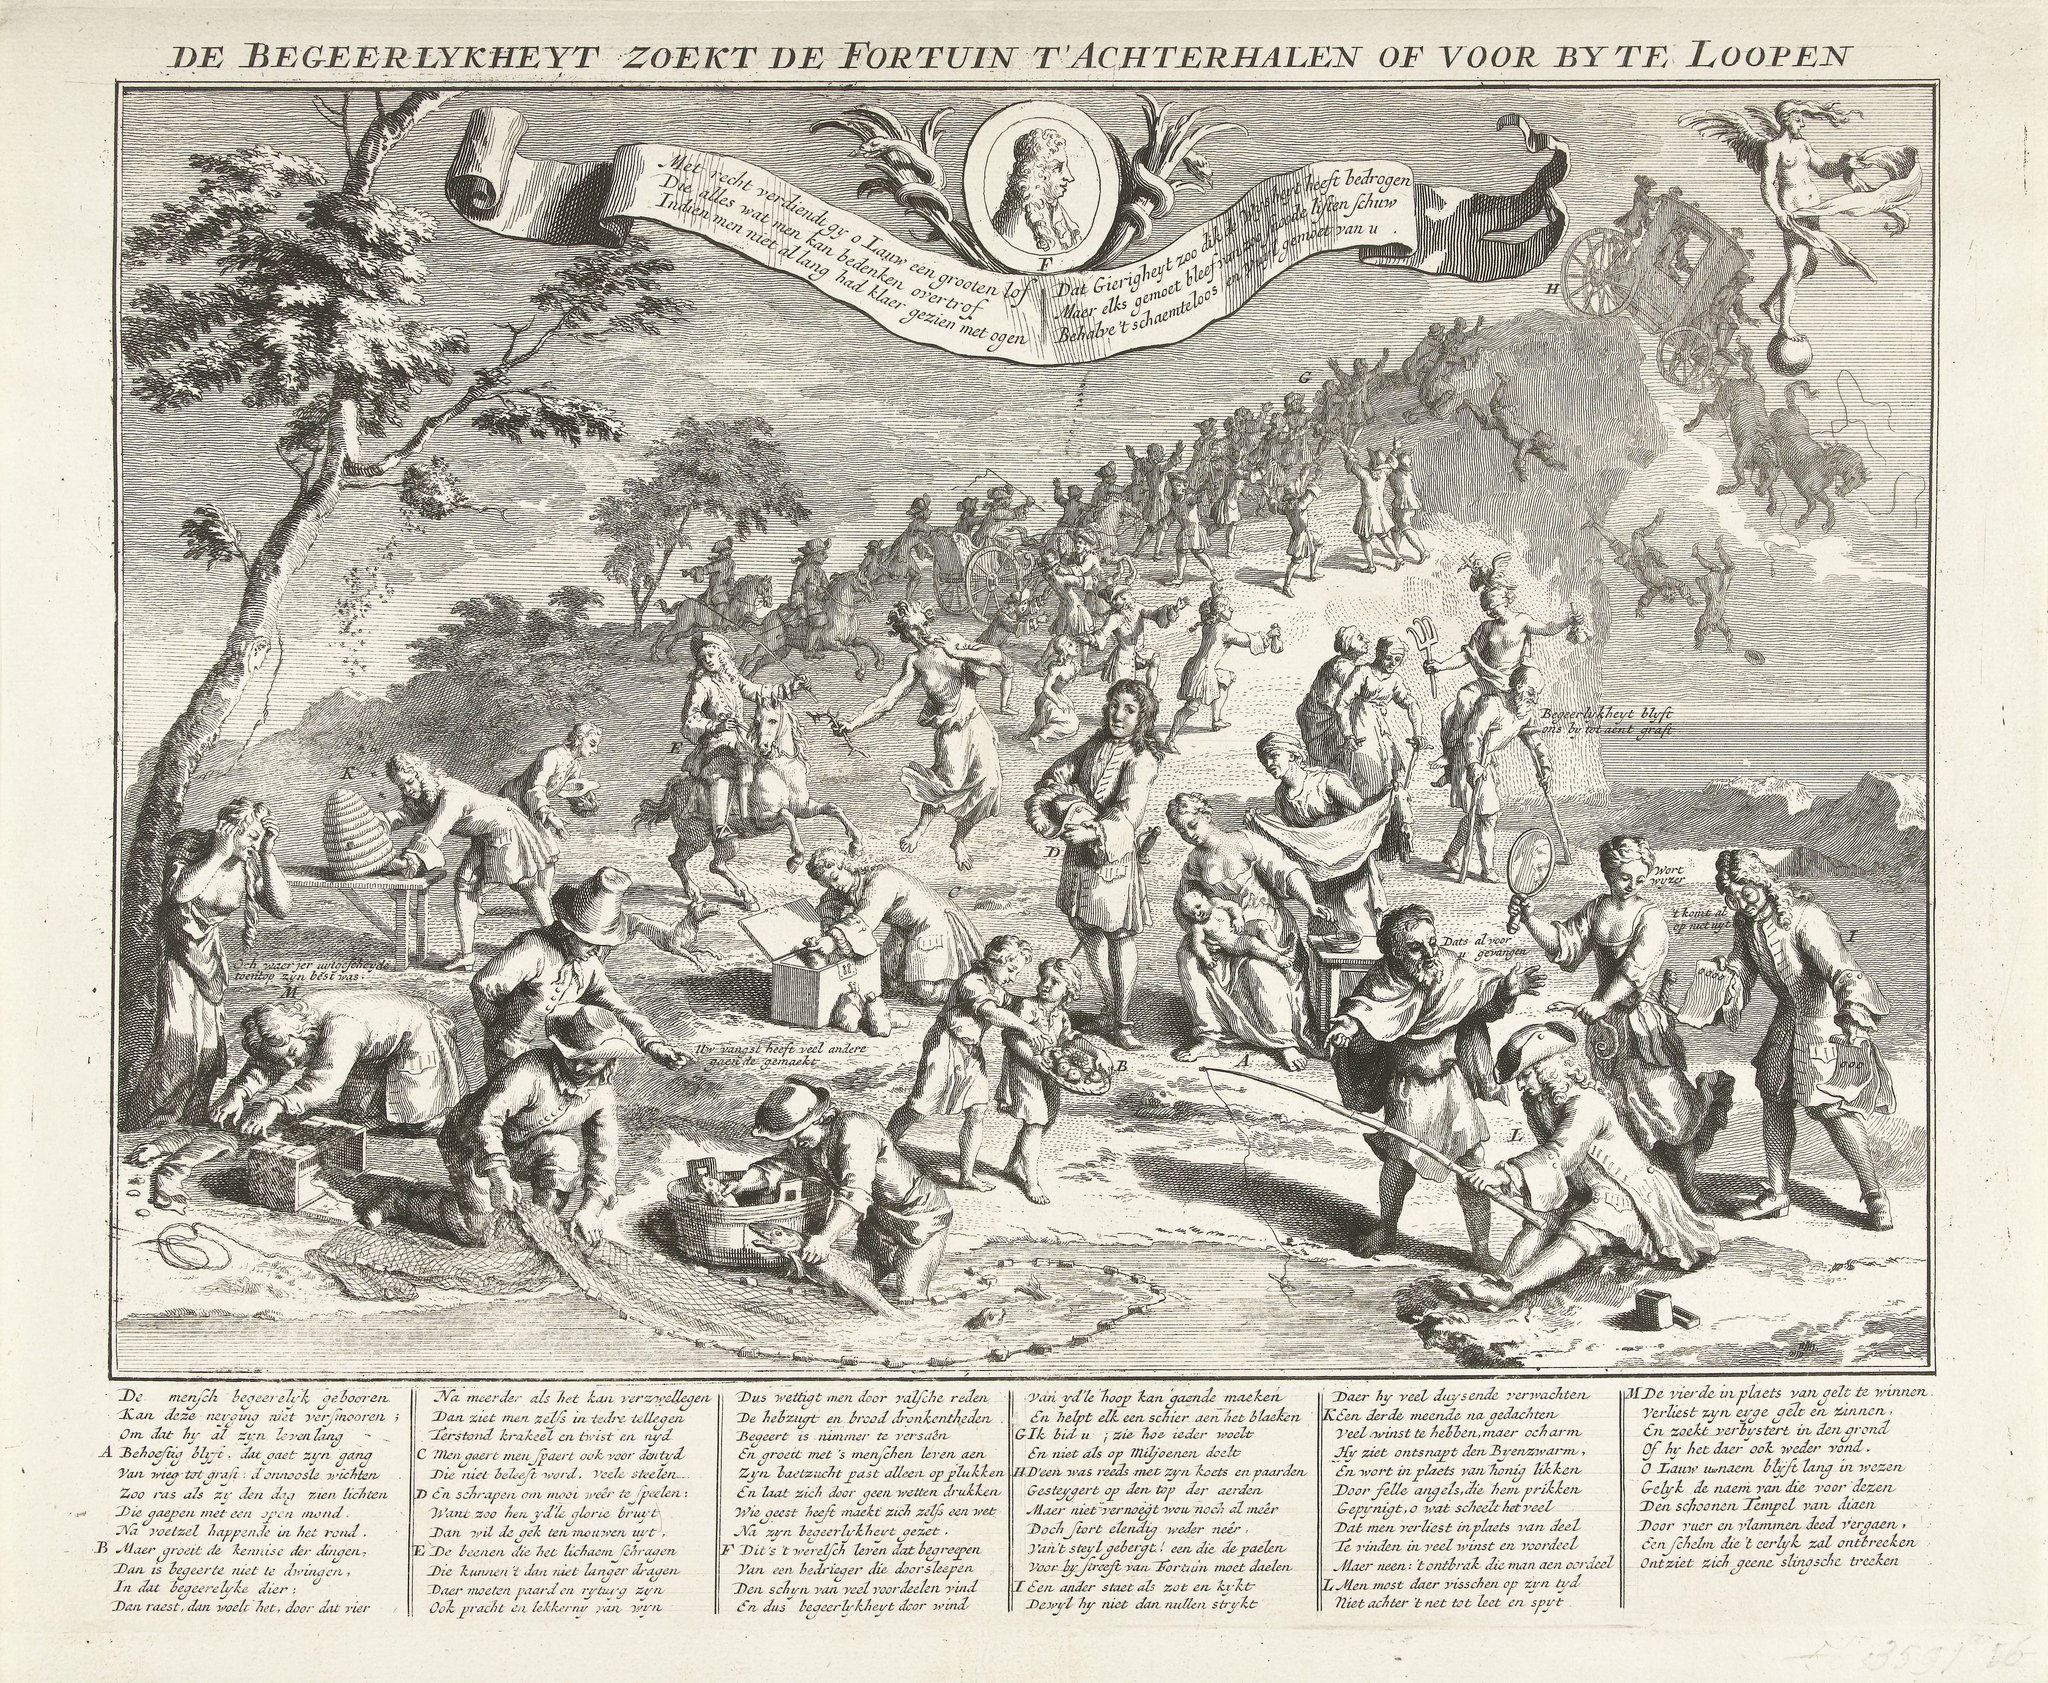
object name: cartoon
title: Het Groote Tafereel der Dwaasheid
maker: Anonymous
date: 1720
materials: paper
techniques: engraving, etching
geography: northern netherlands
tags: luck, fortune, lot; 'fato', 'fortuna', 'fortuna aurea', 'fortuna buona', 'fortuna pacifica overo clemente', 'sorte' (ripa)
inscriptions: collector's mark: Lugt 2228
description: De Hebzucht probeert Fortuna in te halen. Voorstelling van allerlei soorten hebzucht onder de mensen van kinds af aan tot in de ouderdom. Op de achtergrond stort een stoet van windhandelaren te voet en in koetsen zich in achtervolging van Fortuin van een rots in de afgrond. Bovenaan een portret van John Law bij een banderol met zesregelig vers. Met onderschrift in zes kolommen. Prent 56 in de serie Het Groote Tafereel der Dwaasheid met spotprenten op de Windhandel of Actiehandel van 1720.